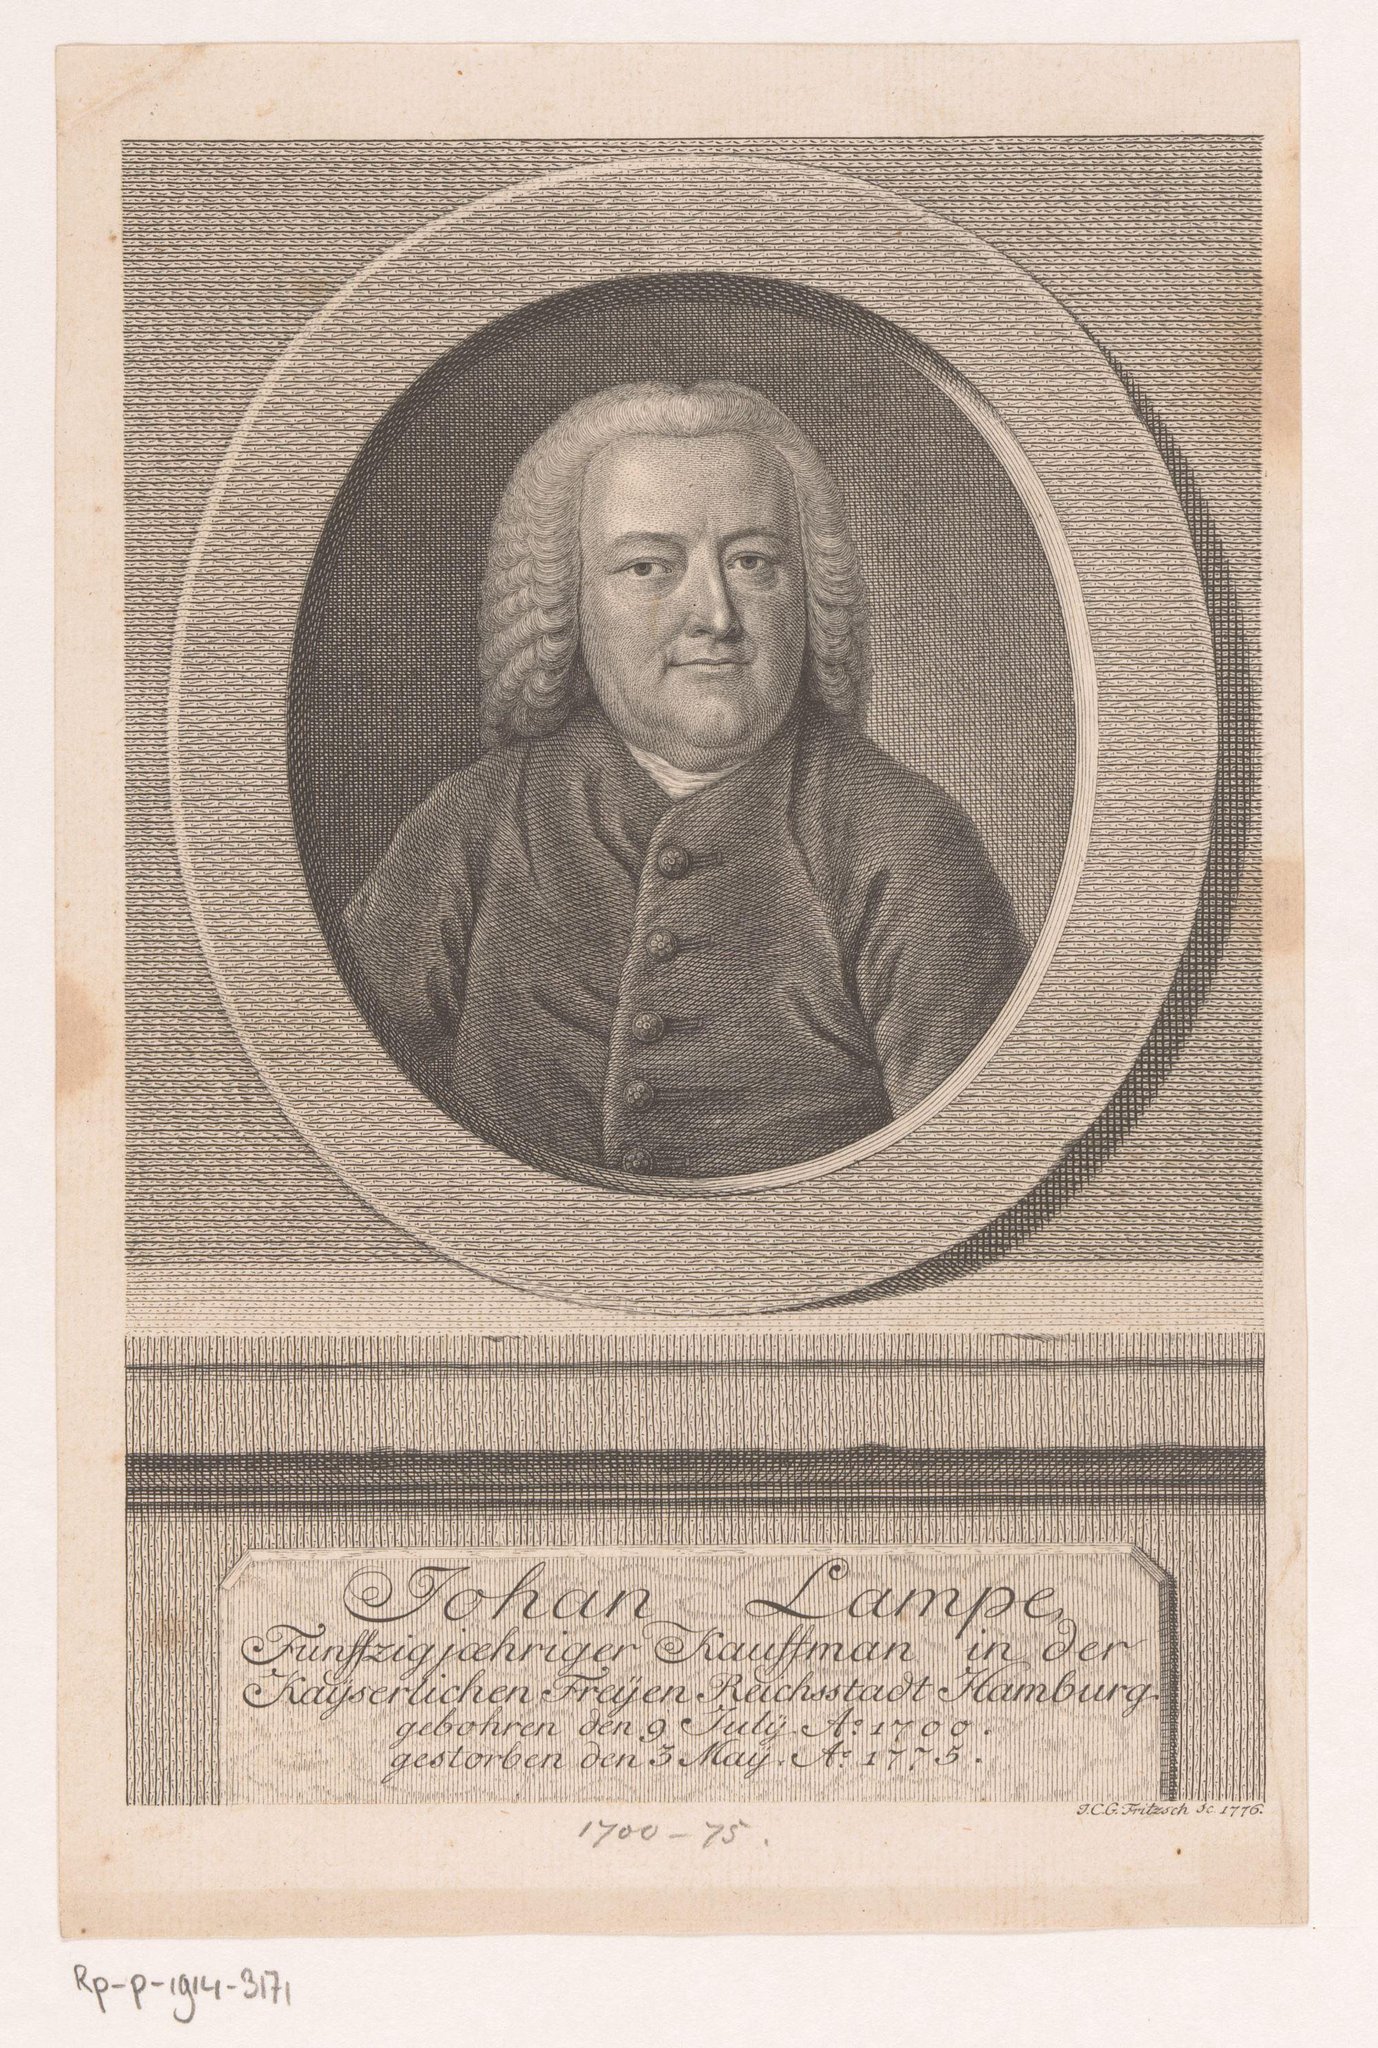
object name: print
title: Portret van Johan Lampe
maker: johann christian gottfried fritzsch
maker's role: print maker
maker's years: 1720-1802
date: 1776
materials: paper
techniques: engraving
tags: ornament ~ medallion, historical persons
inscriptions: collector's mark: Lugt 2228